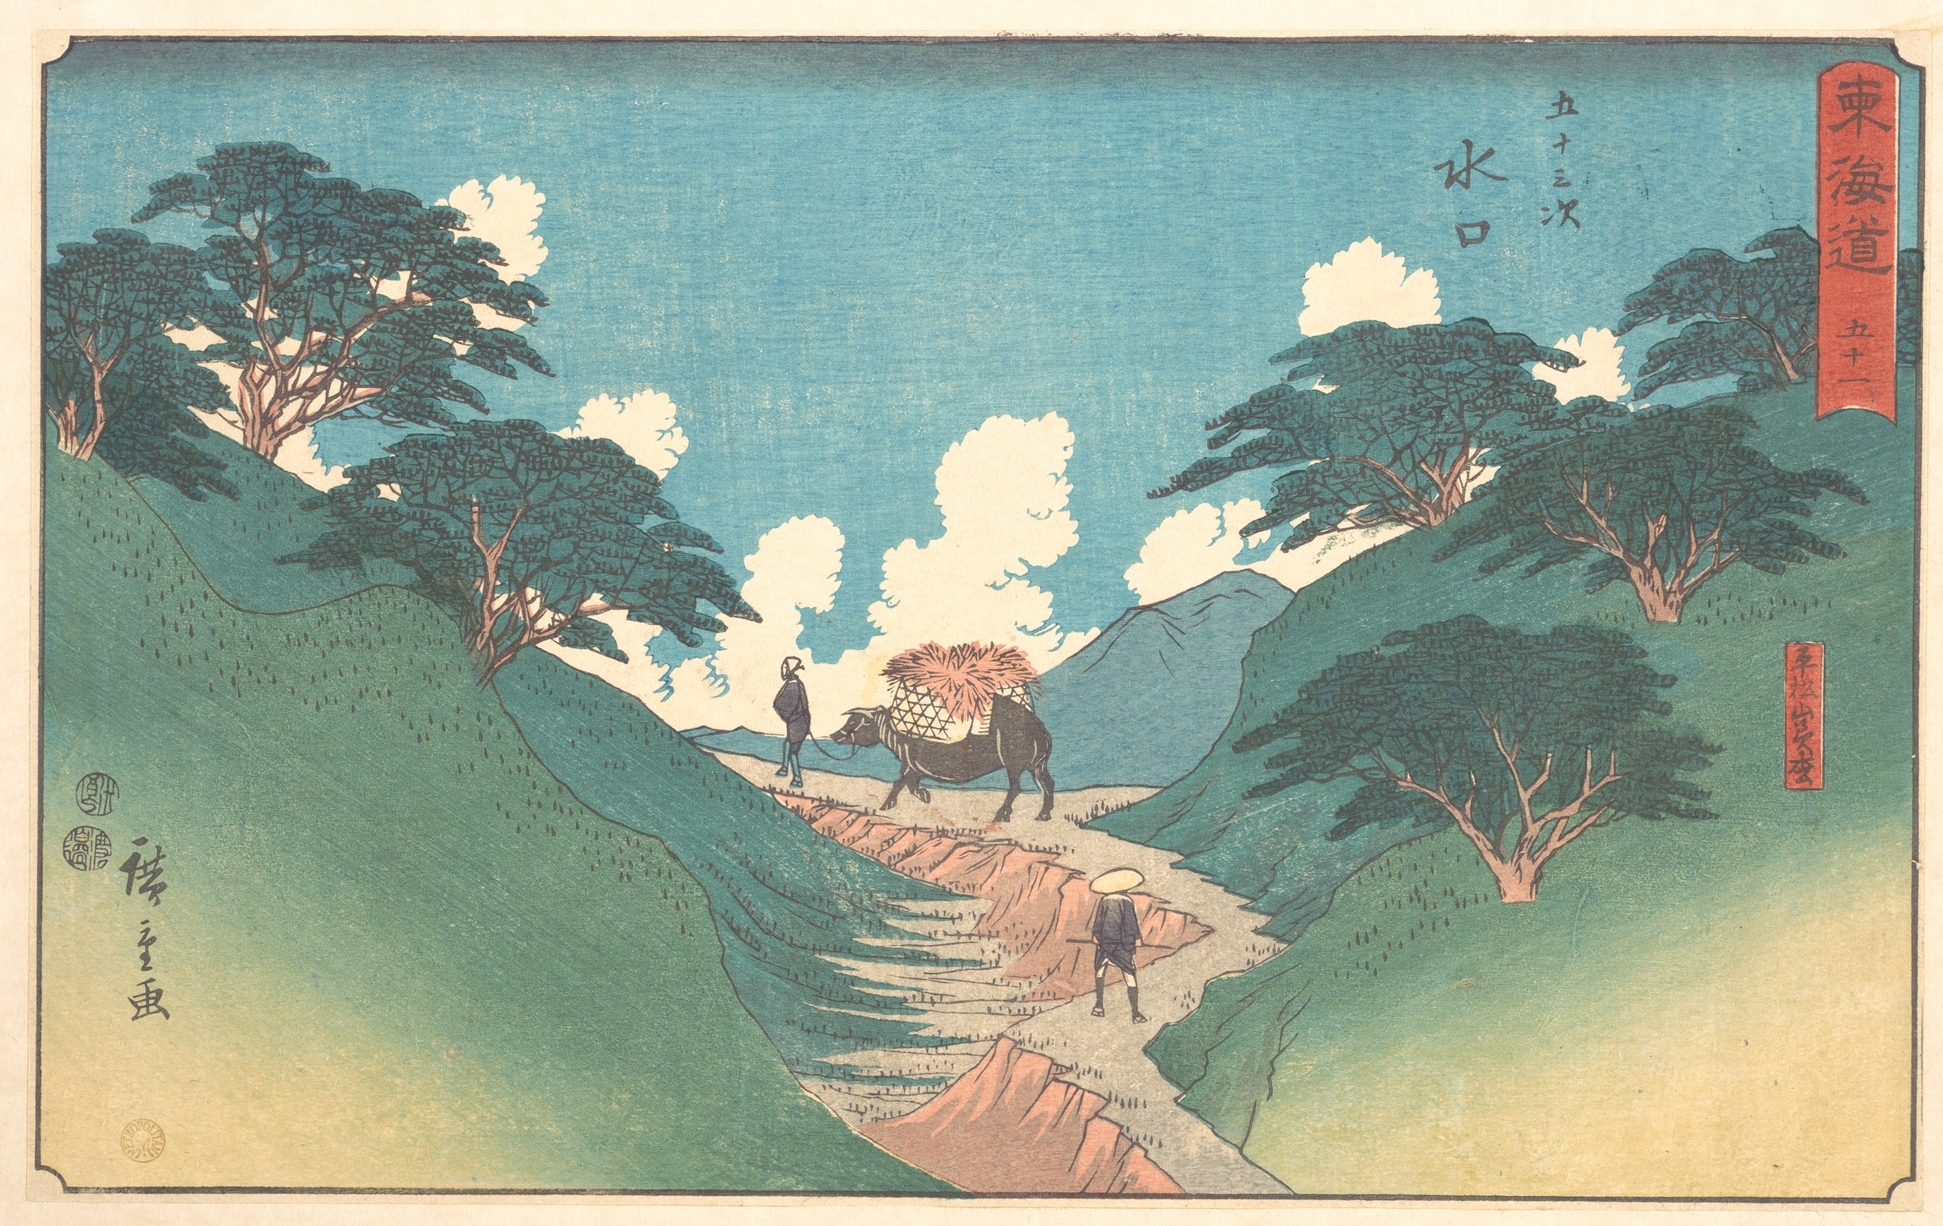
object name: print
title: Minaguchi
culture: japanese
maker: utagawa hiroshige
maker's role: artist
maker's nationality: japanese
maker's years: 1797-1858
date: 1840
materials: ink, paper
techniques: woodblock print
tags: human figures,animals,hills,trees